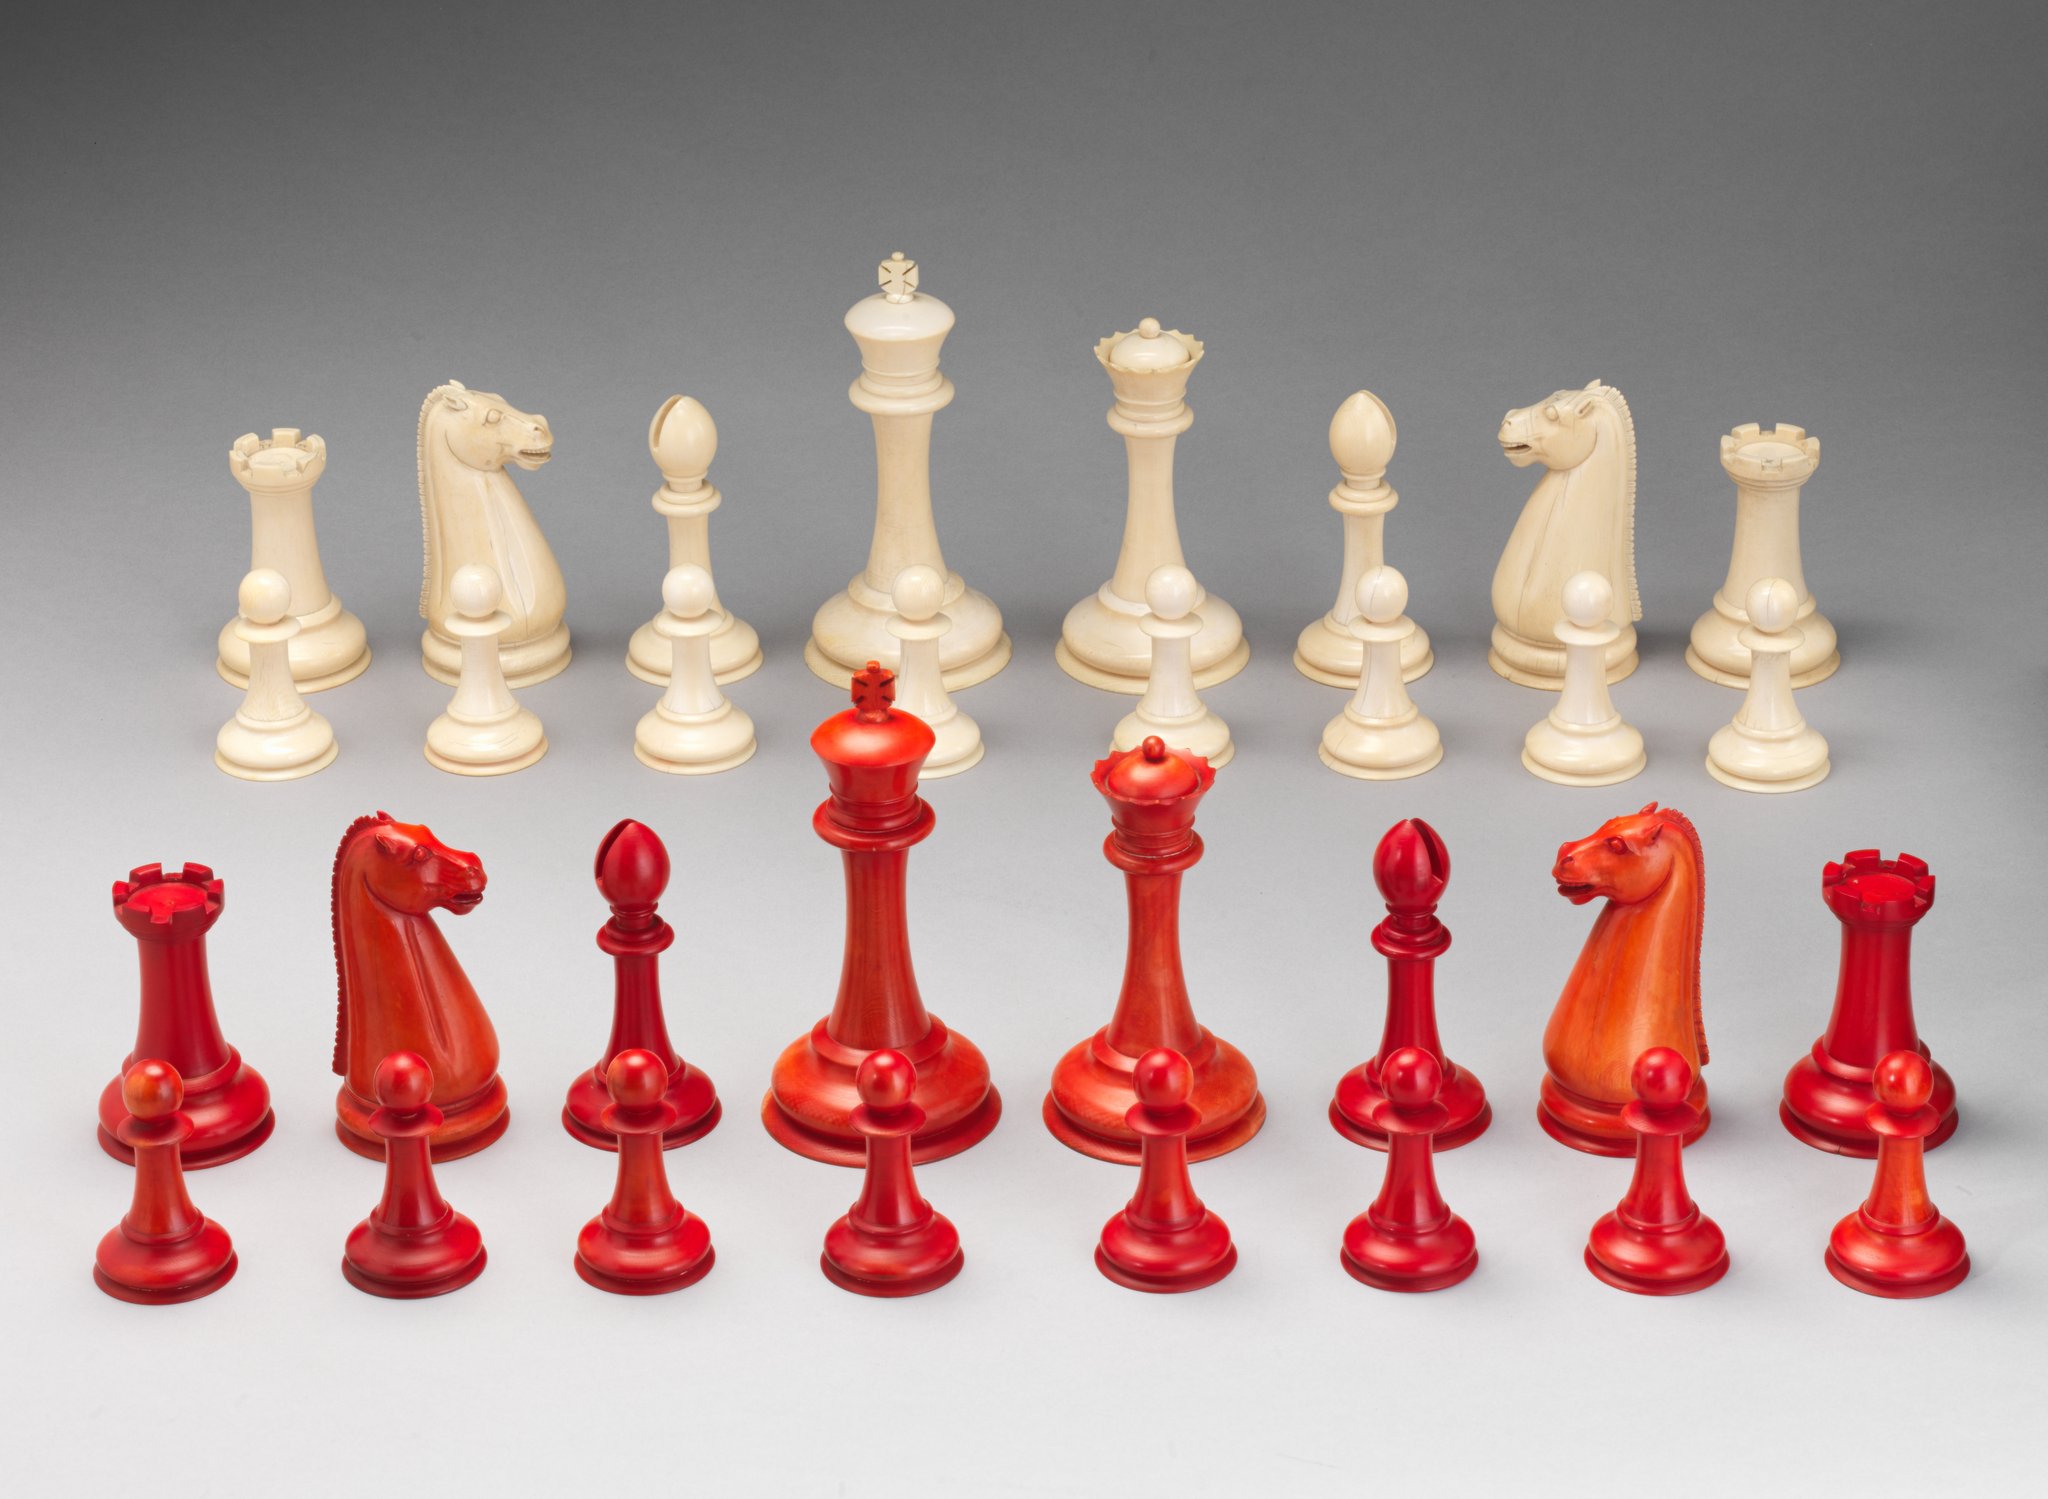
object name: chessman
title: Chessmen (32)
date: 1853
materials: ivory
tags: chess,games